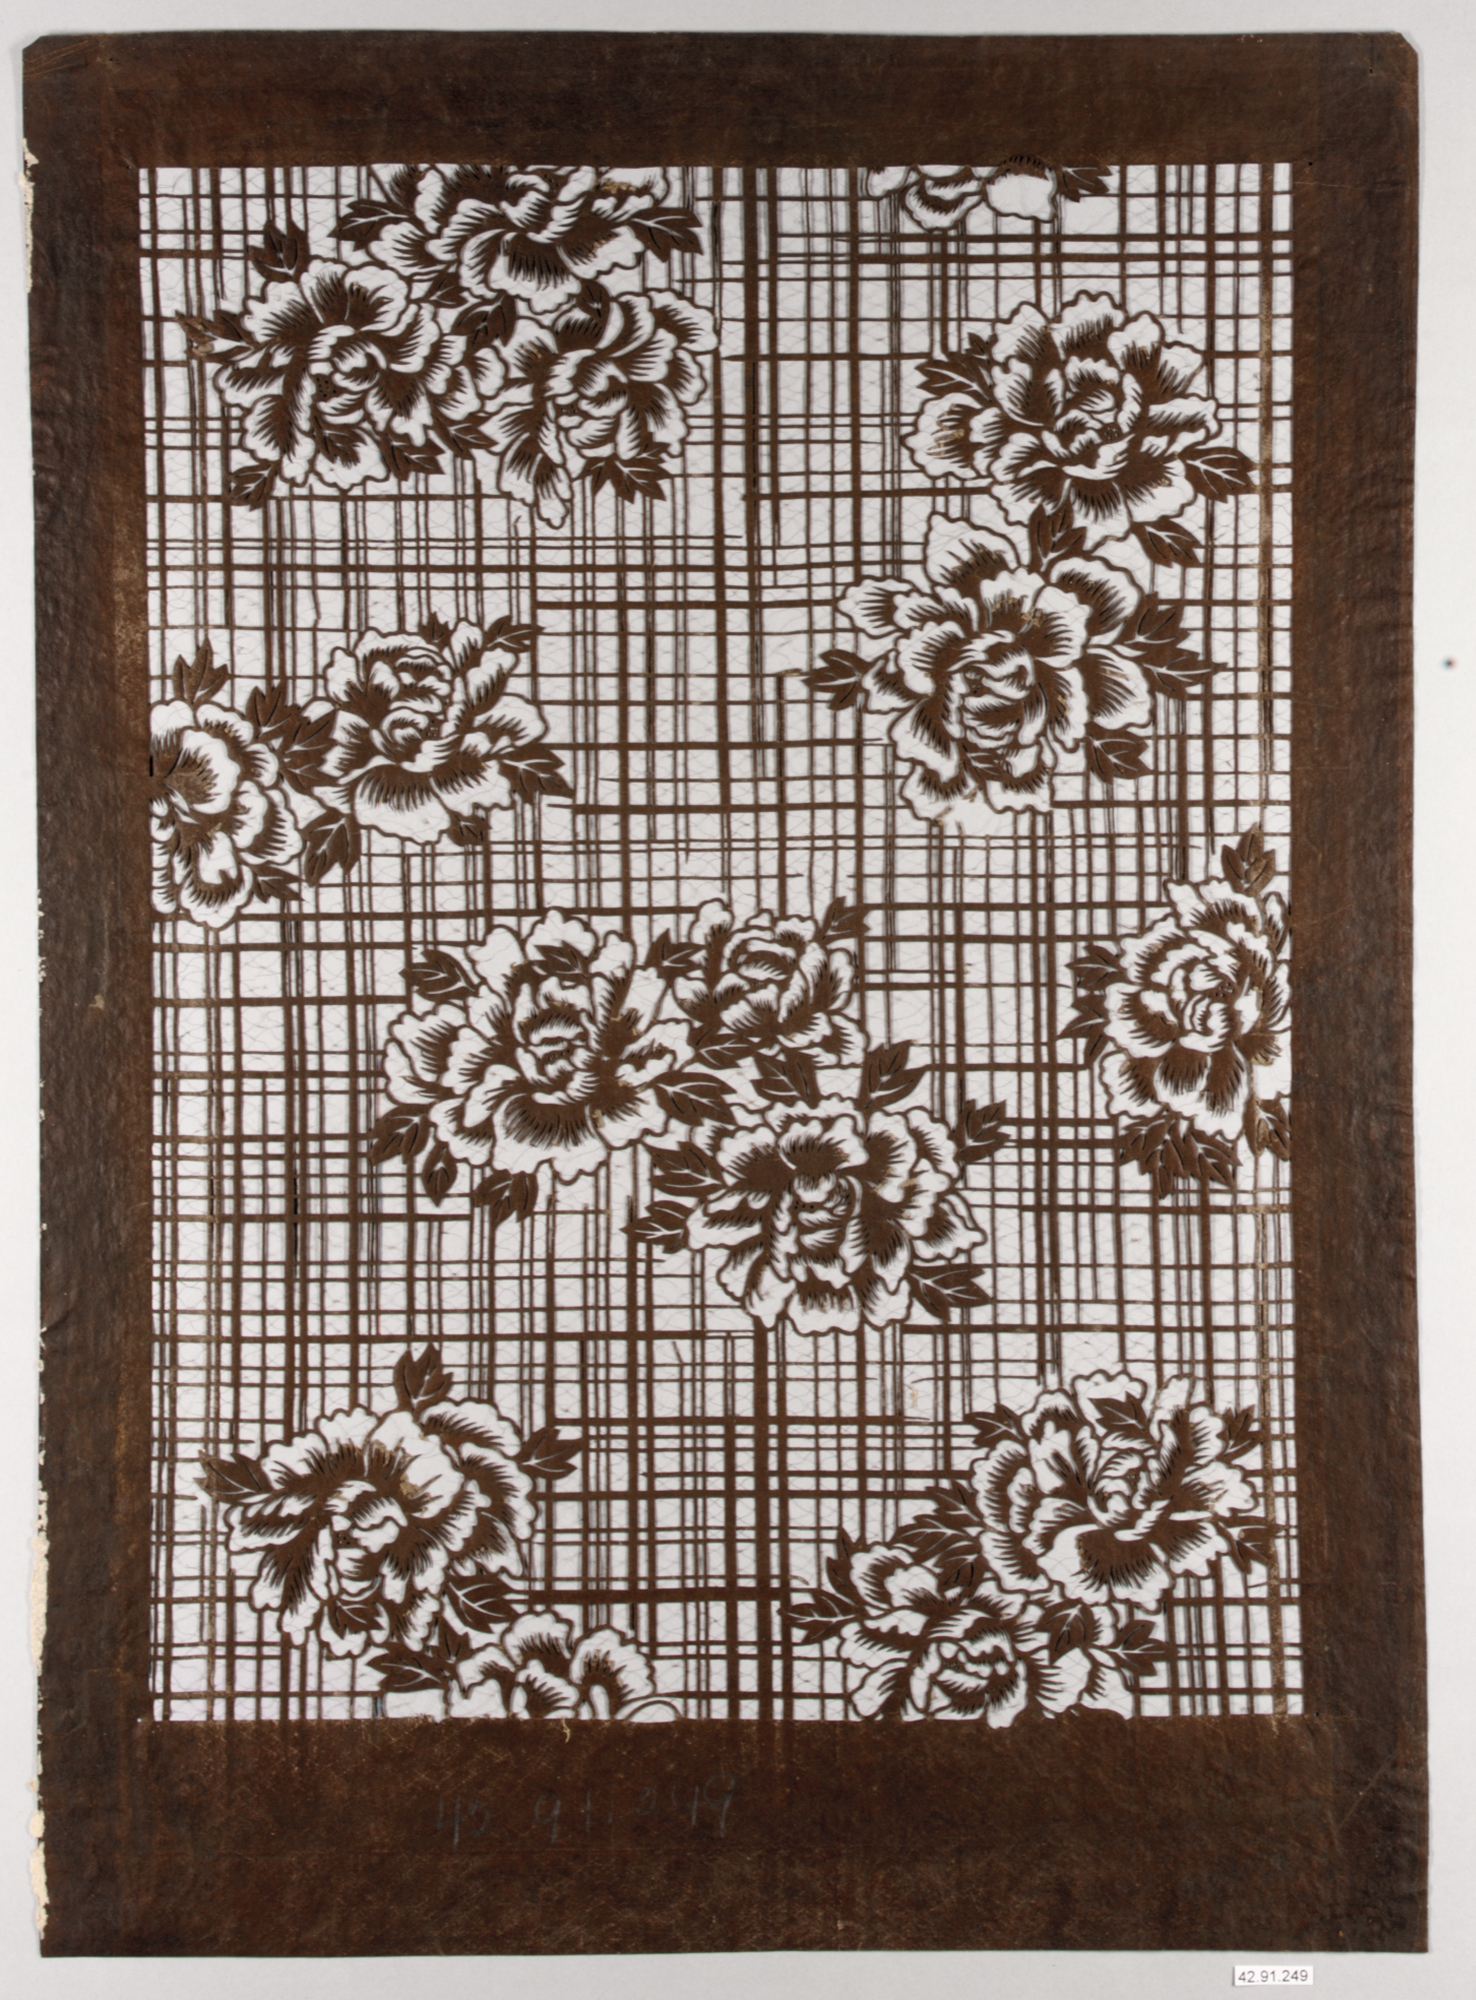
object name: stencil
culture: japanese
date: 1801-1900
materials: paper, silk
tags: flowers